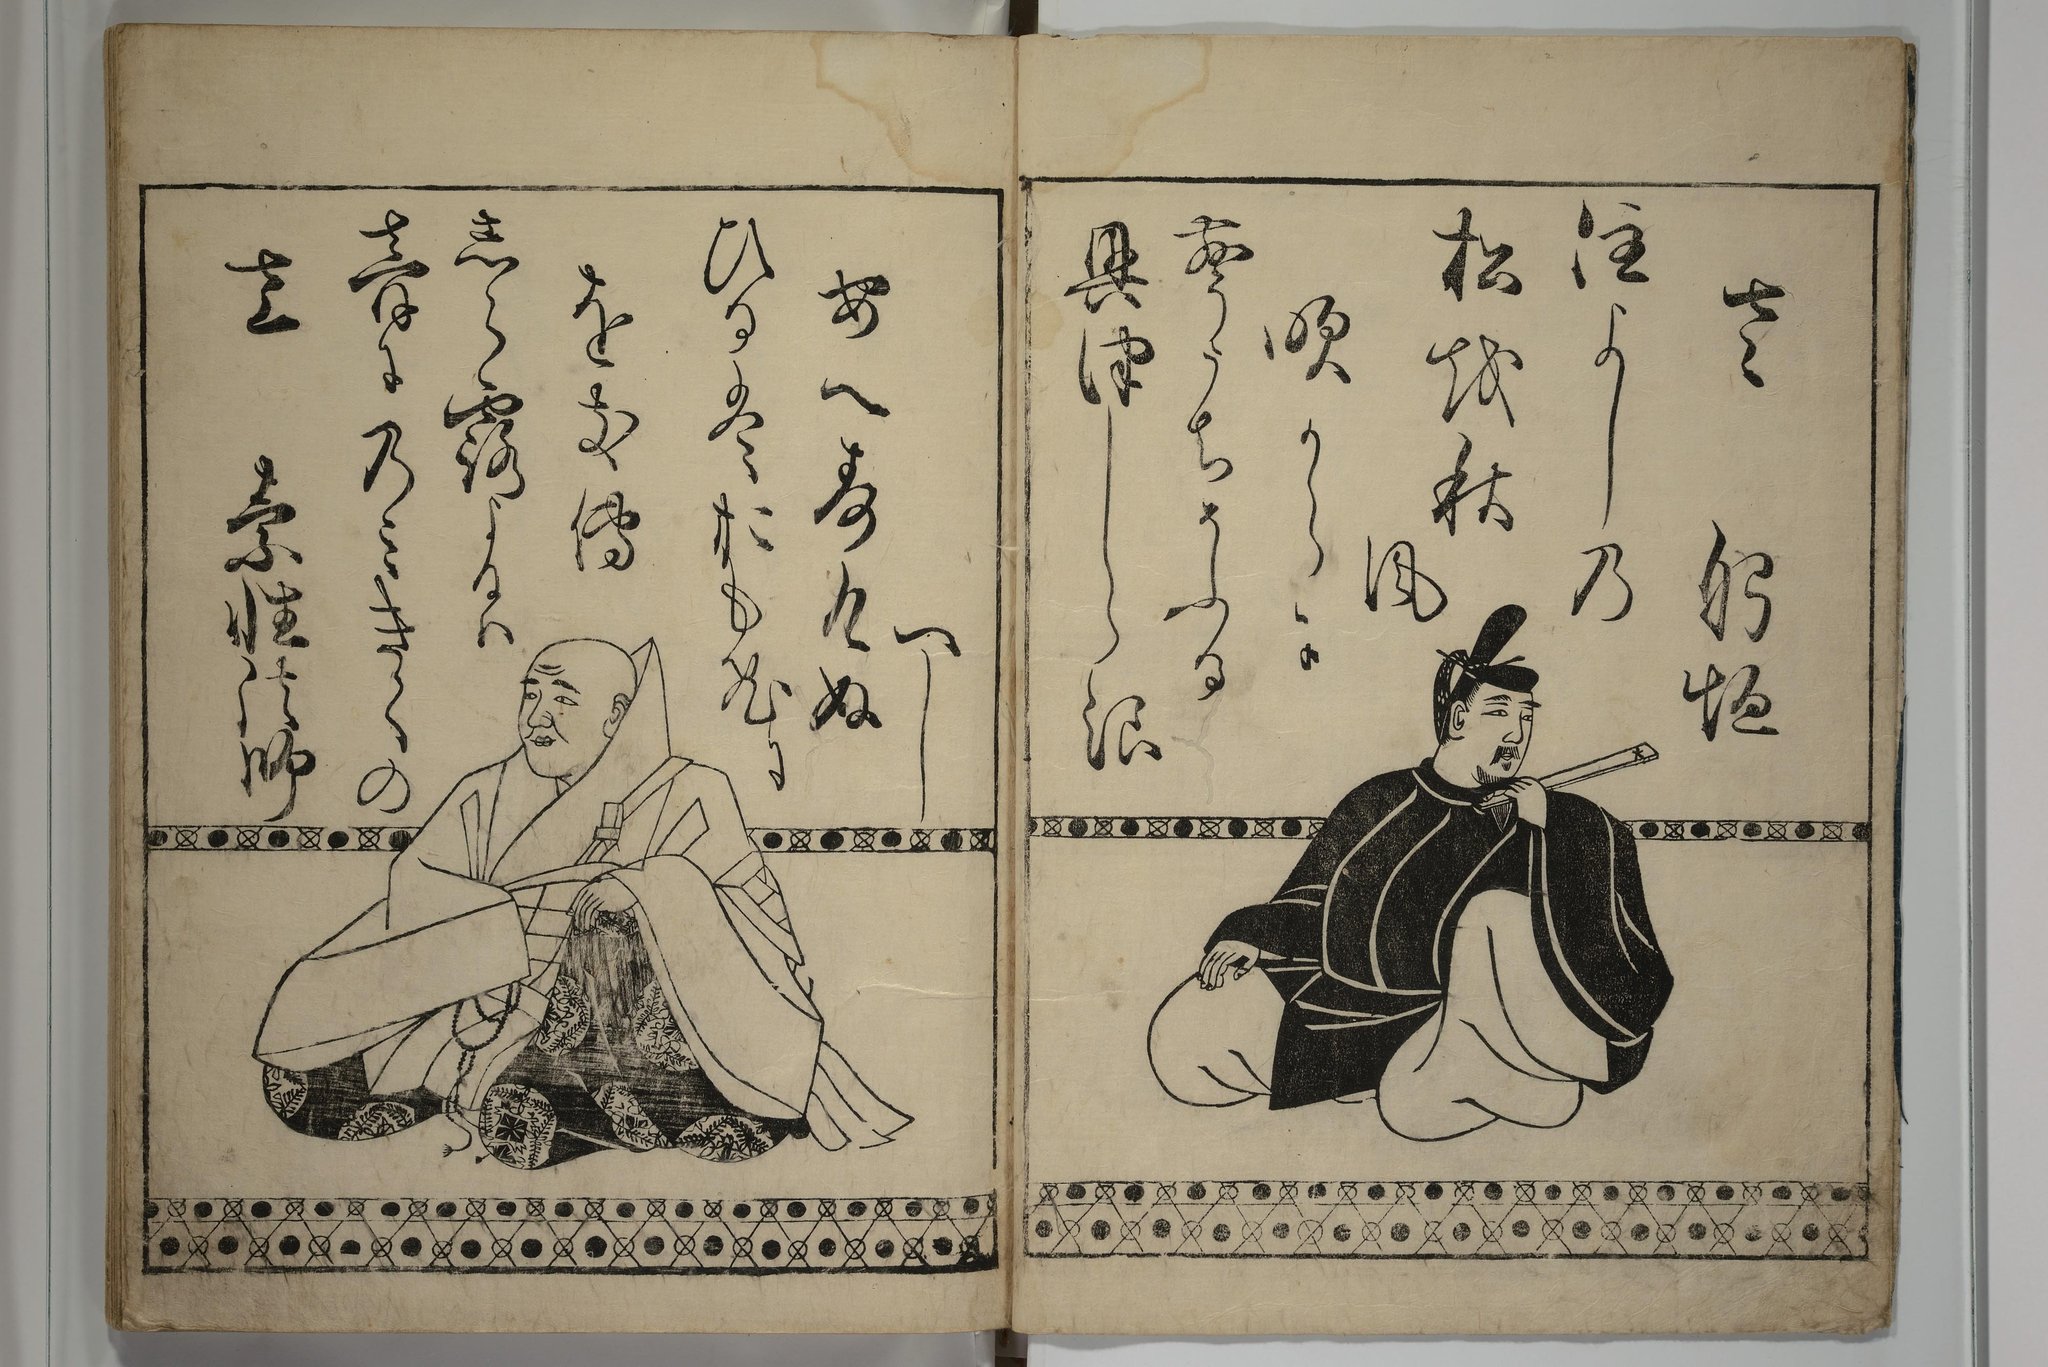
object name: illustrated book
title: The “Kōetsu Version” of Waka Poems of the Thirty-six Immortals of Poetry (Kōetsu-bon Waka Sanjūrokkasen) 和歌三十歌仙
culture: japanese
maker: unidentified artist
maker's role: artist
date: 1610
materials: ink, paper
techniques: woodblock print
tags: poetry,men,poets